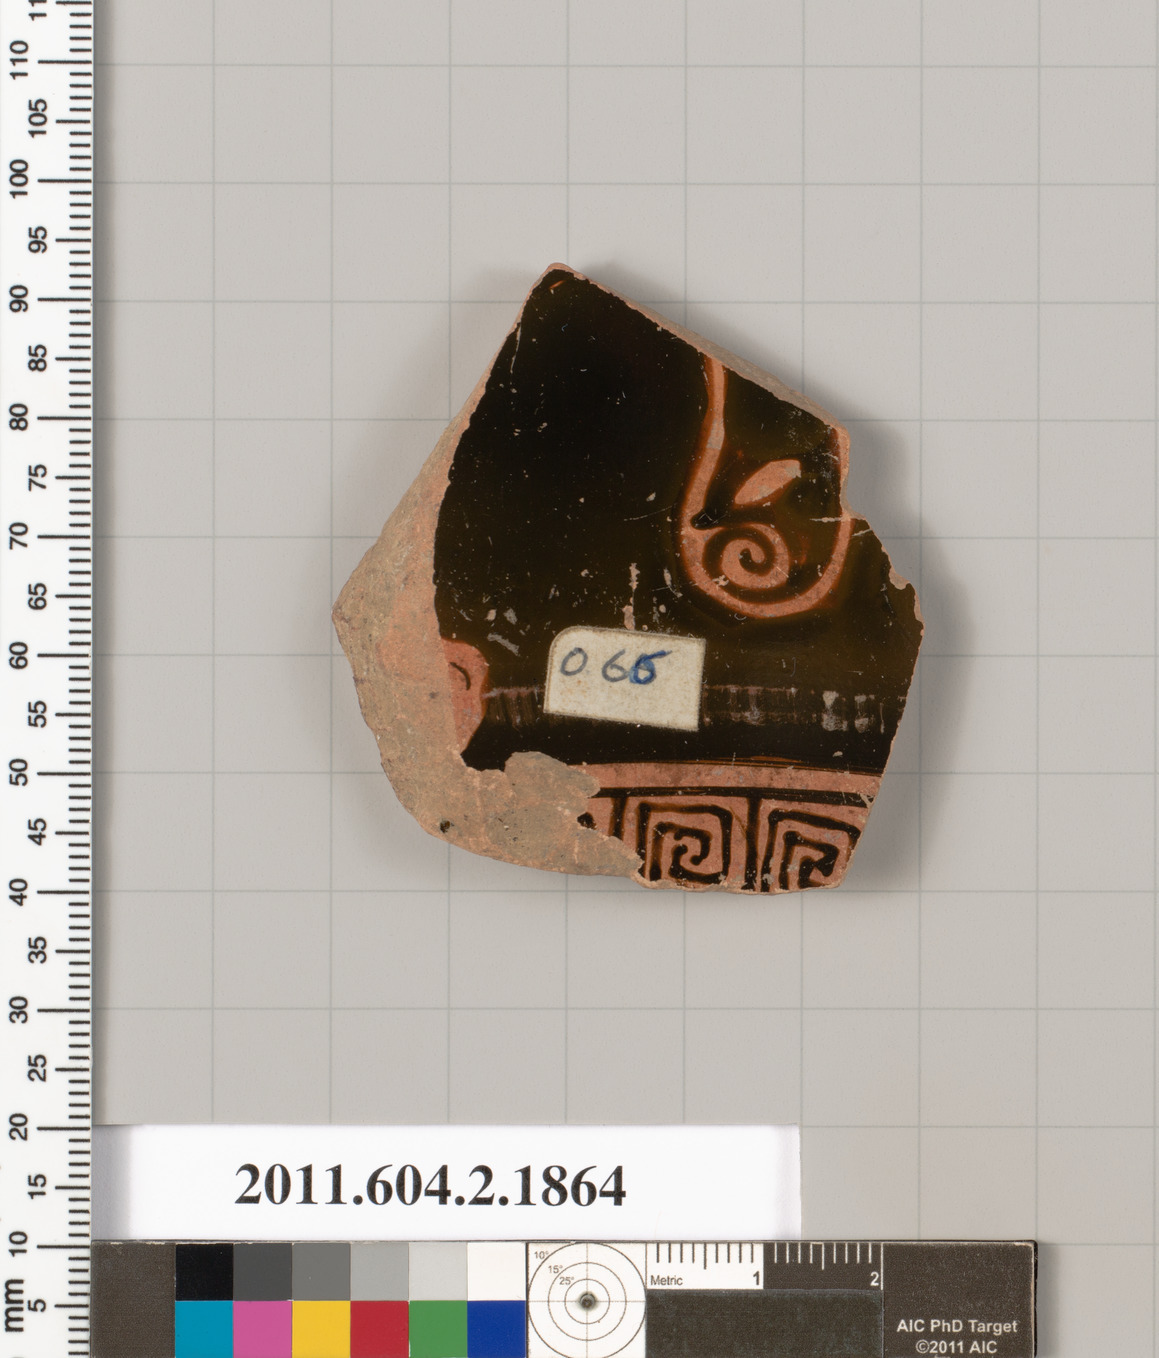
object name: skyphos fragment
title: Terracotta fragment of a skyphos (deep drinking cup)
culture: greek, attic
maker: penthesilea painter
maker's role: artist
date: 460-450 BCE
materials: terracotta